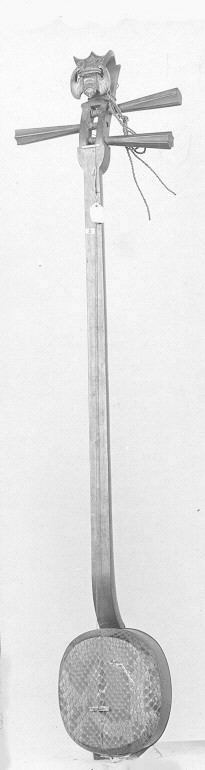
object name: sanxian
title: Sanxian (三弦 )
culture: chinese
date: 1801-1900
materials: wood, skin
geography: china